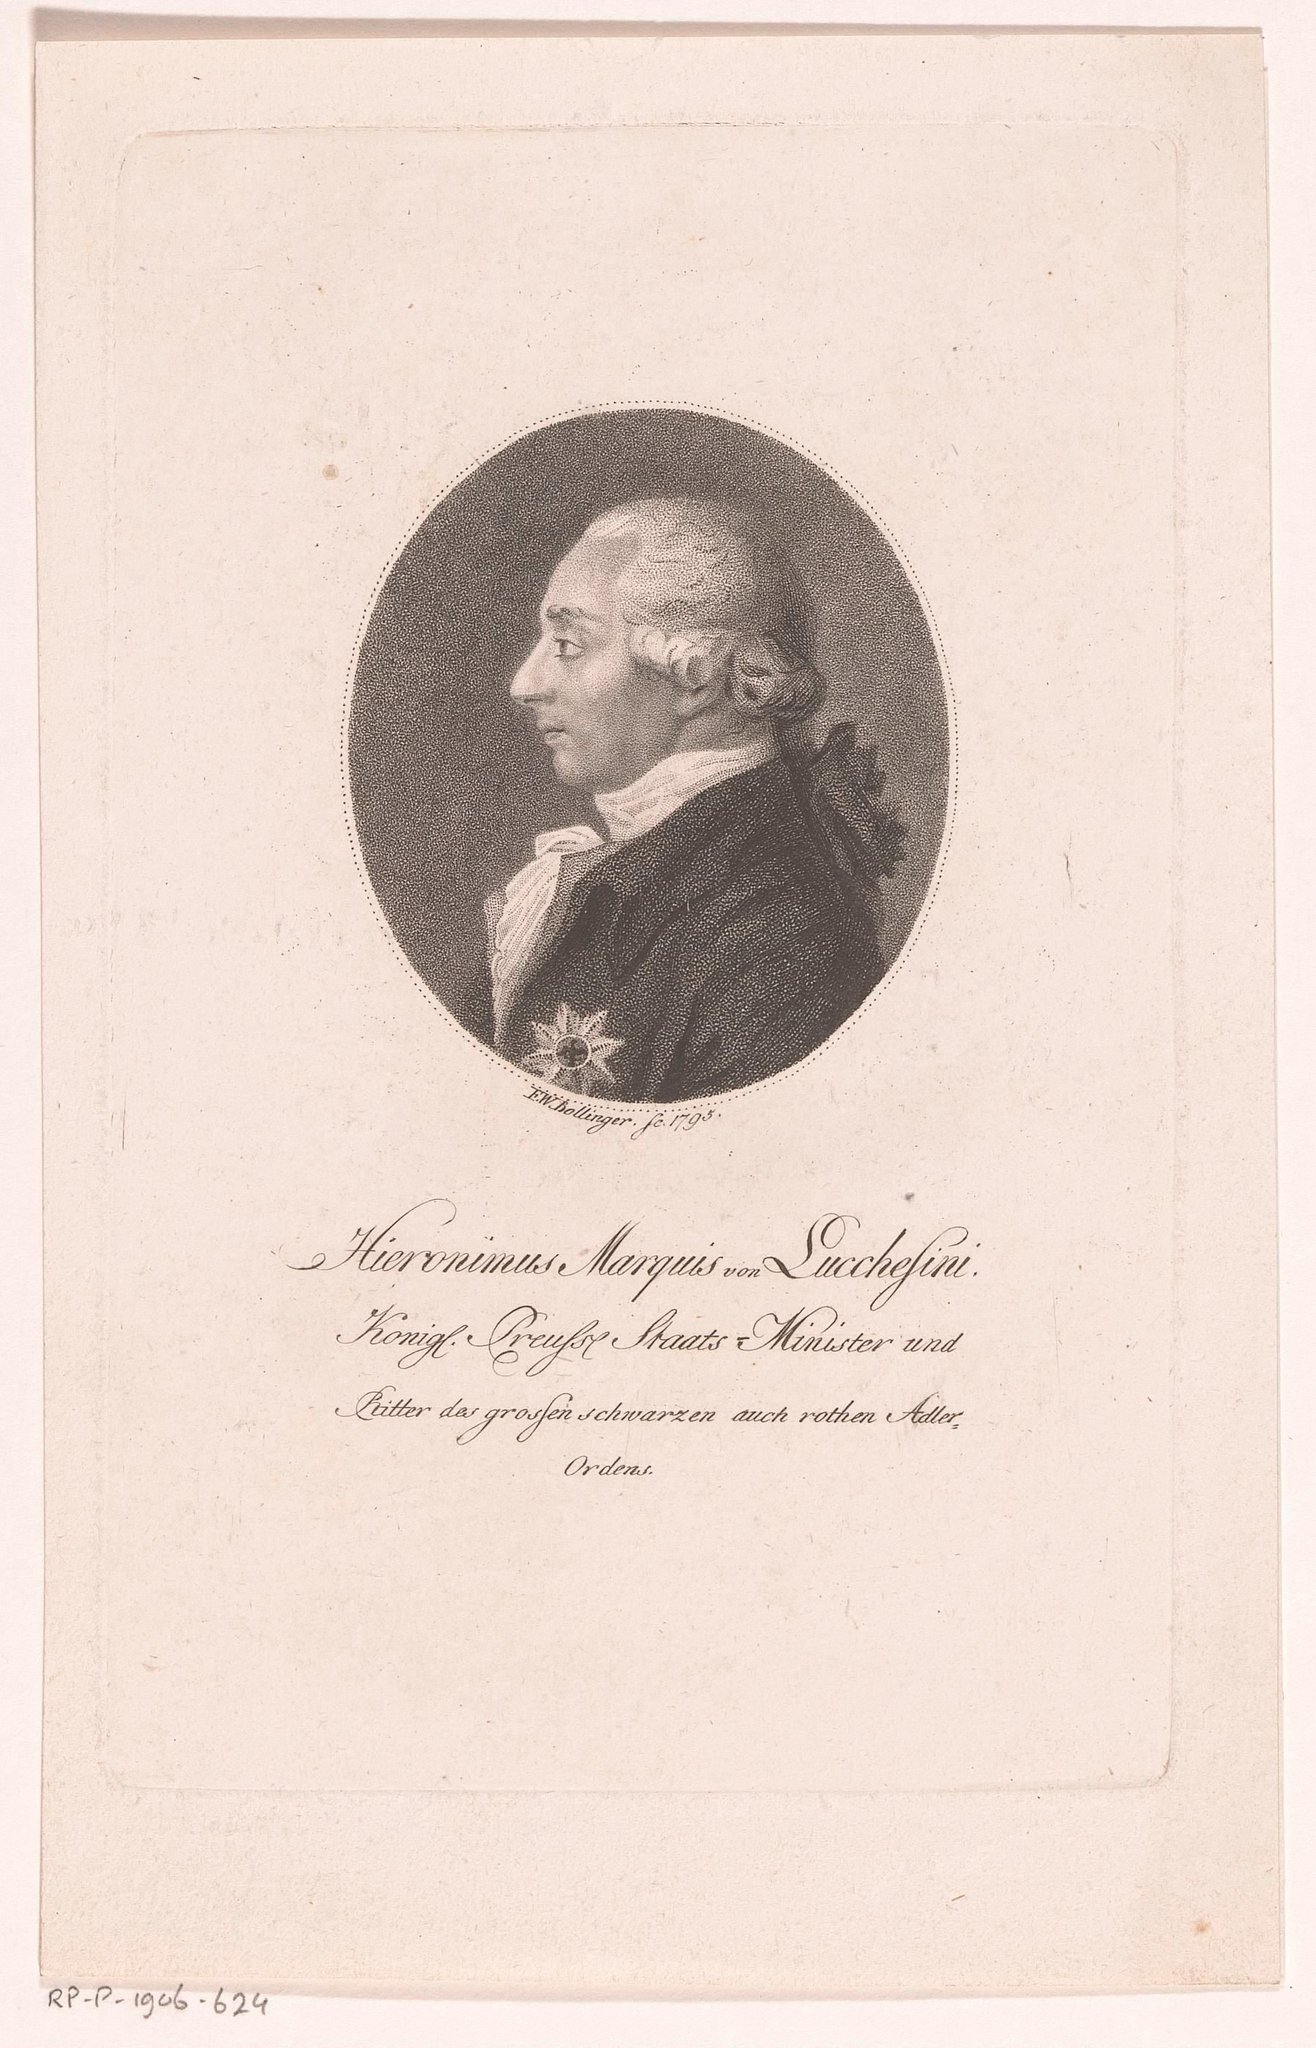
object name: print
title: Portret van Girolamo Lucchesini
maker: friedrich wilhelm bollinger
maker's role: print maker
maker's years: 1777-1825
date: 1795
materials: paper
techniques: stippling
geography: berlin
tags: knighthood order (with name) - insignia of a knighthood order, e.g.: badge, chain (with name of order), historical persons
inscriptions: collector's mark: Lugt 2228